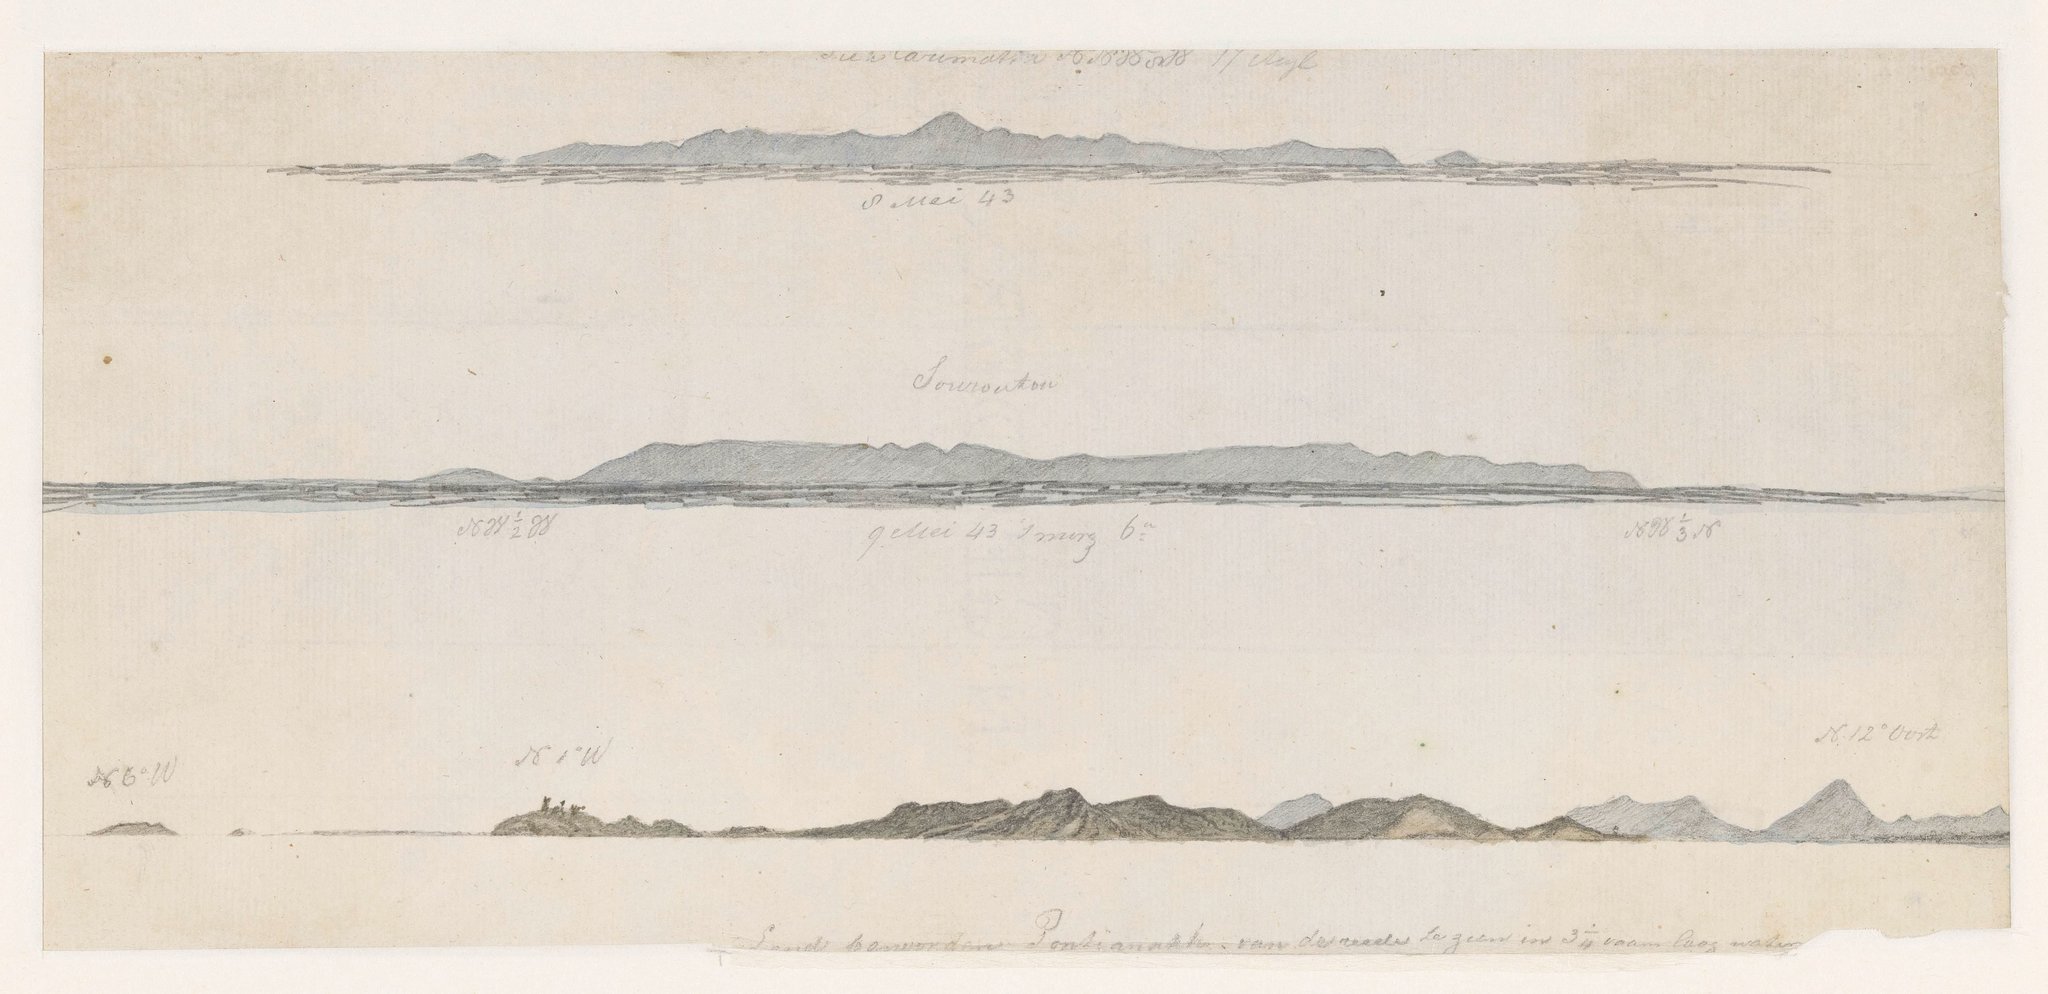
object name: drawing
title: Drie kustprofielen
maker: j. g. van der does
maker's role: draughtsman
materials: ink, paper, pencil, watercolor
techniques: brush, pen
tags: rocky coast, coast, mountains, souronto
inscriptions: date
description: Verschillende opschriften handgeschreven in potlood waaronder geografische coördinaten.